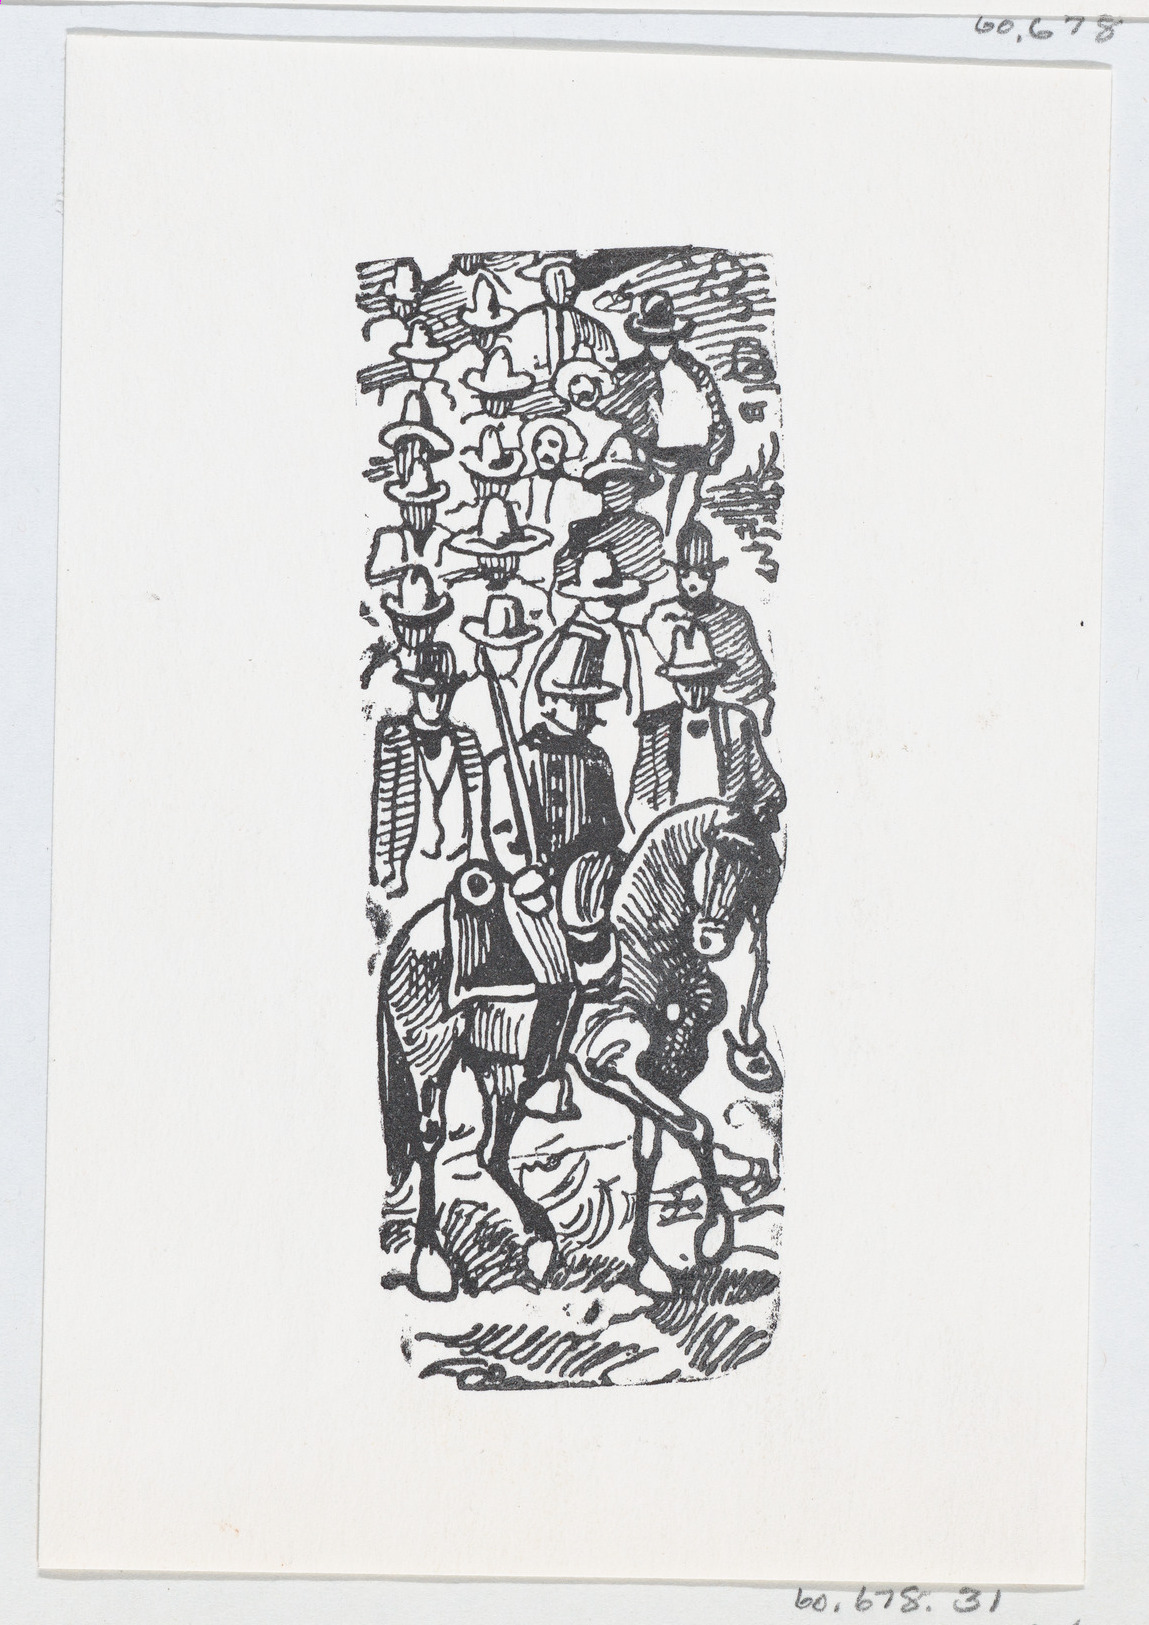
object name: print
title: A group of men following a soldier on horseback with a sword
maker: josé guadalupe posada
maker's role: artist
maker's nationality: mexican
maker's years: 1852-1913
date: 1910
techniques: lithography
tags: soldiers,men,horses